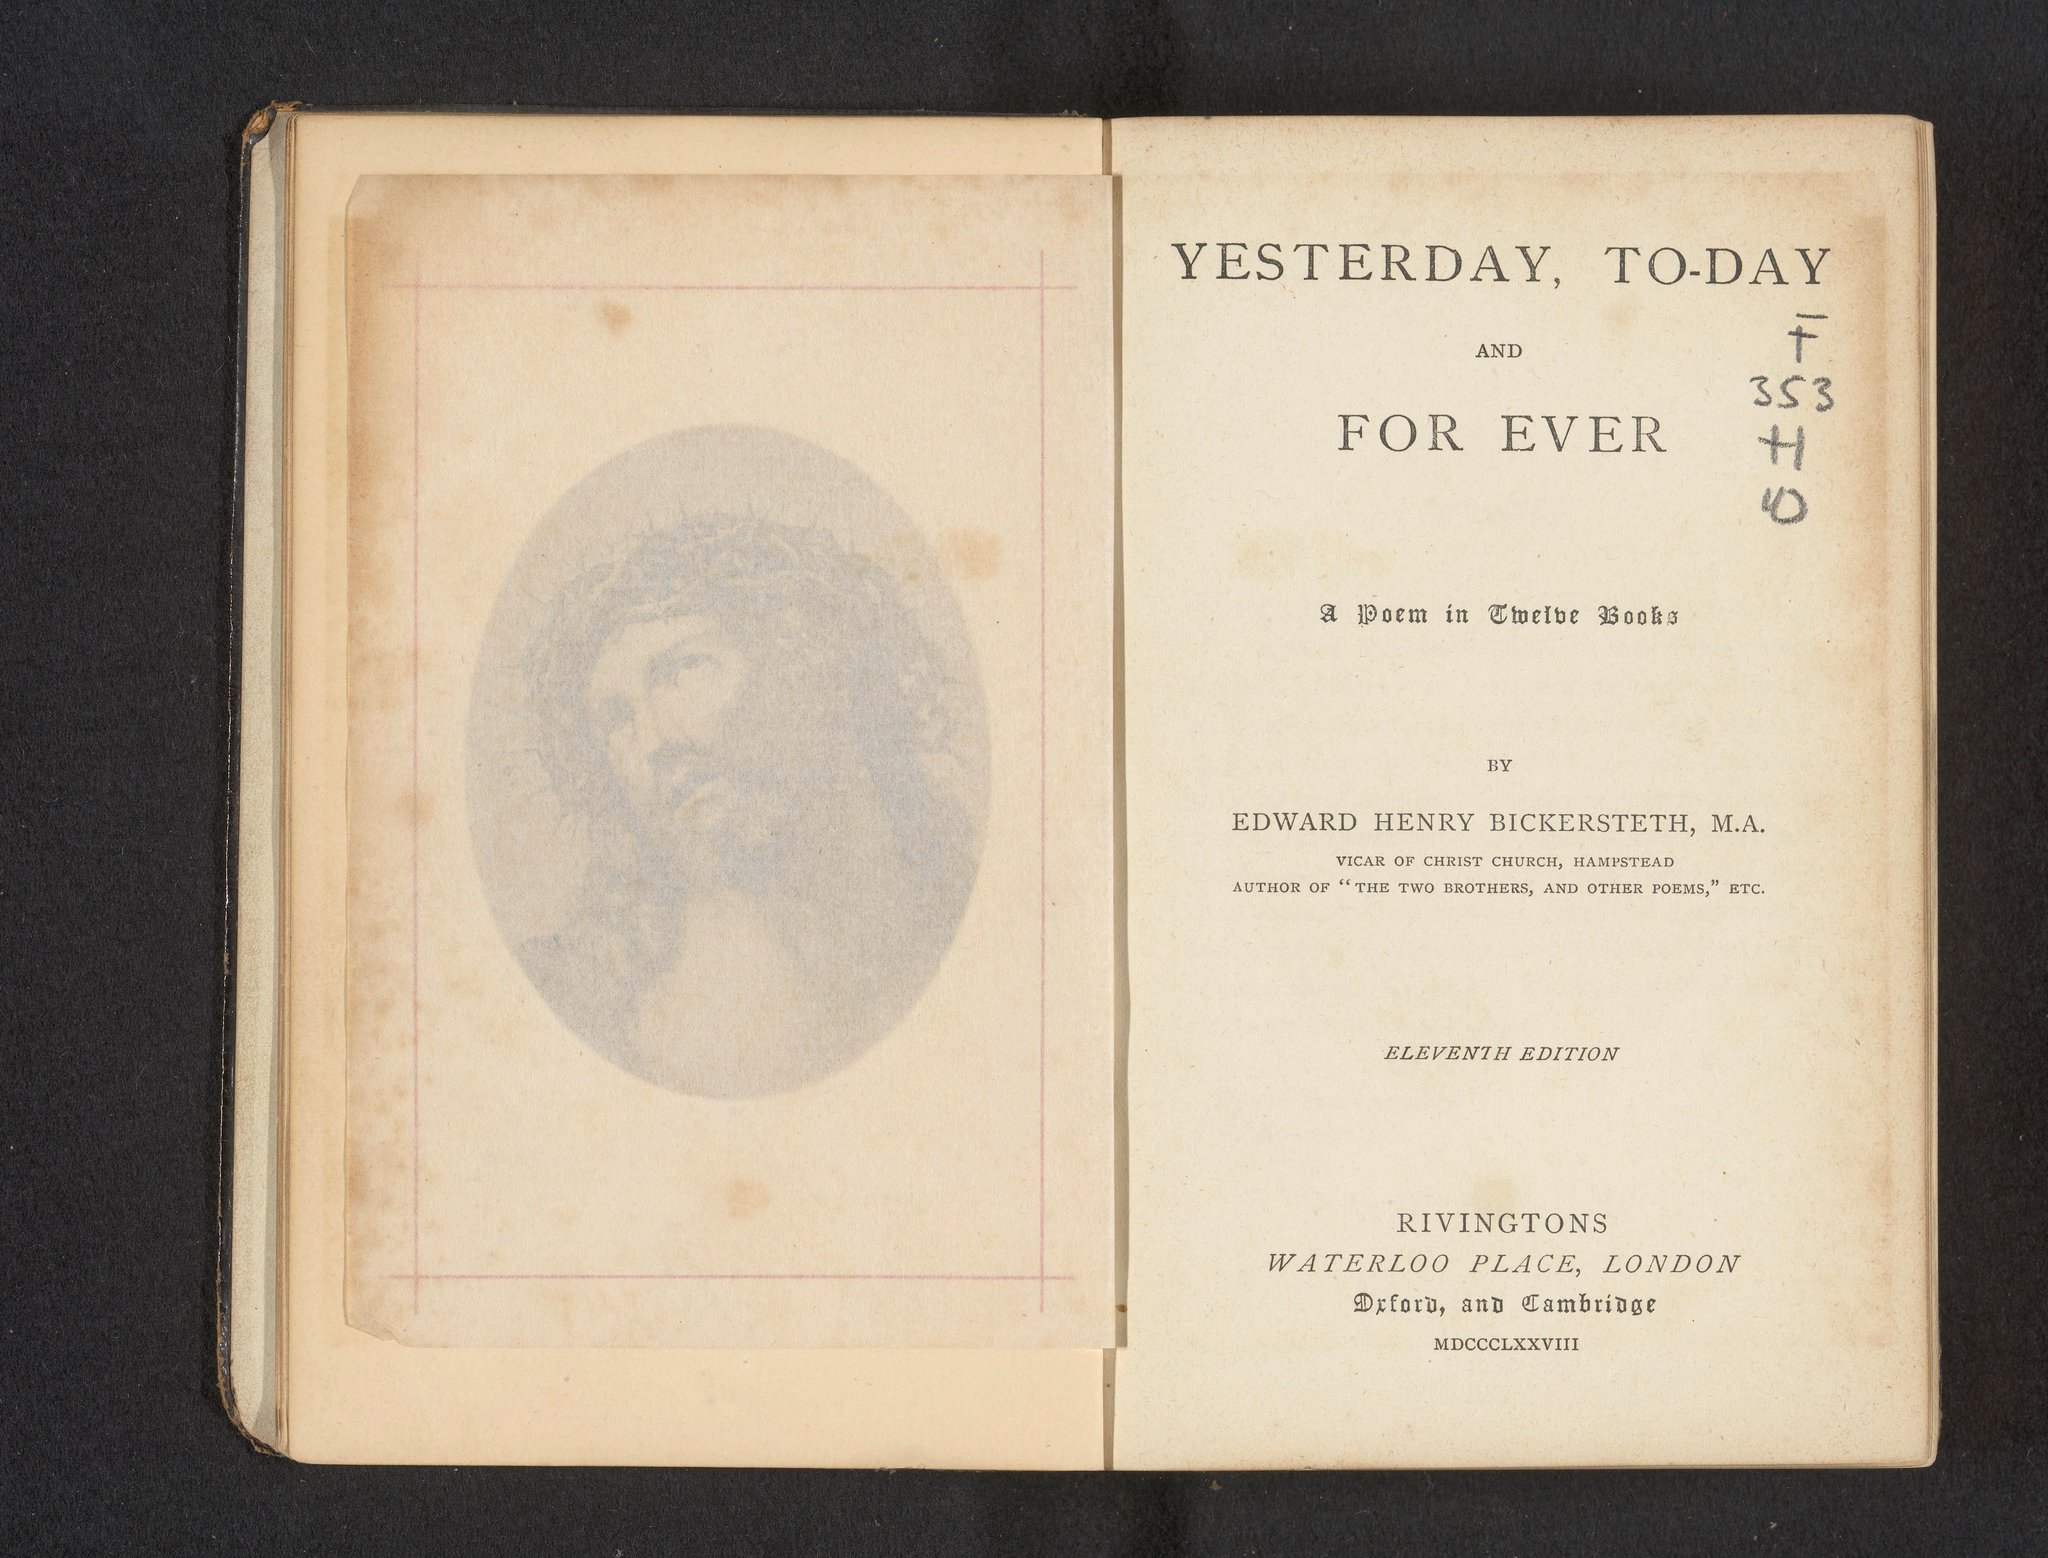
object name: book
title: Yesterday, today and for ever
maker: cora kennedy aitken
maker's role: schrijver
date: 1878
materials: cardboard, linen, paper, photographic support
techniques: albumen print, printing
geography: london